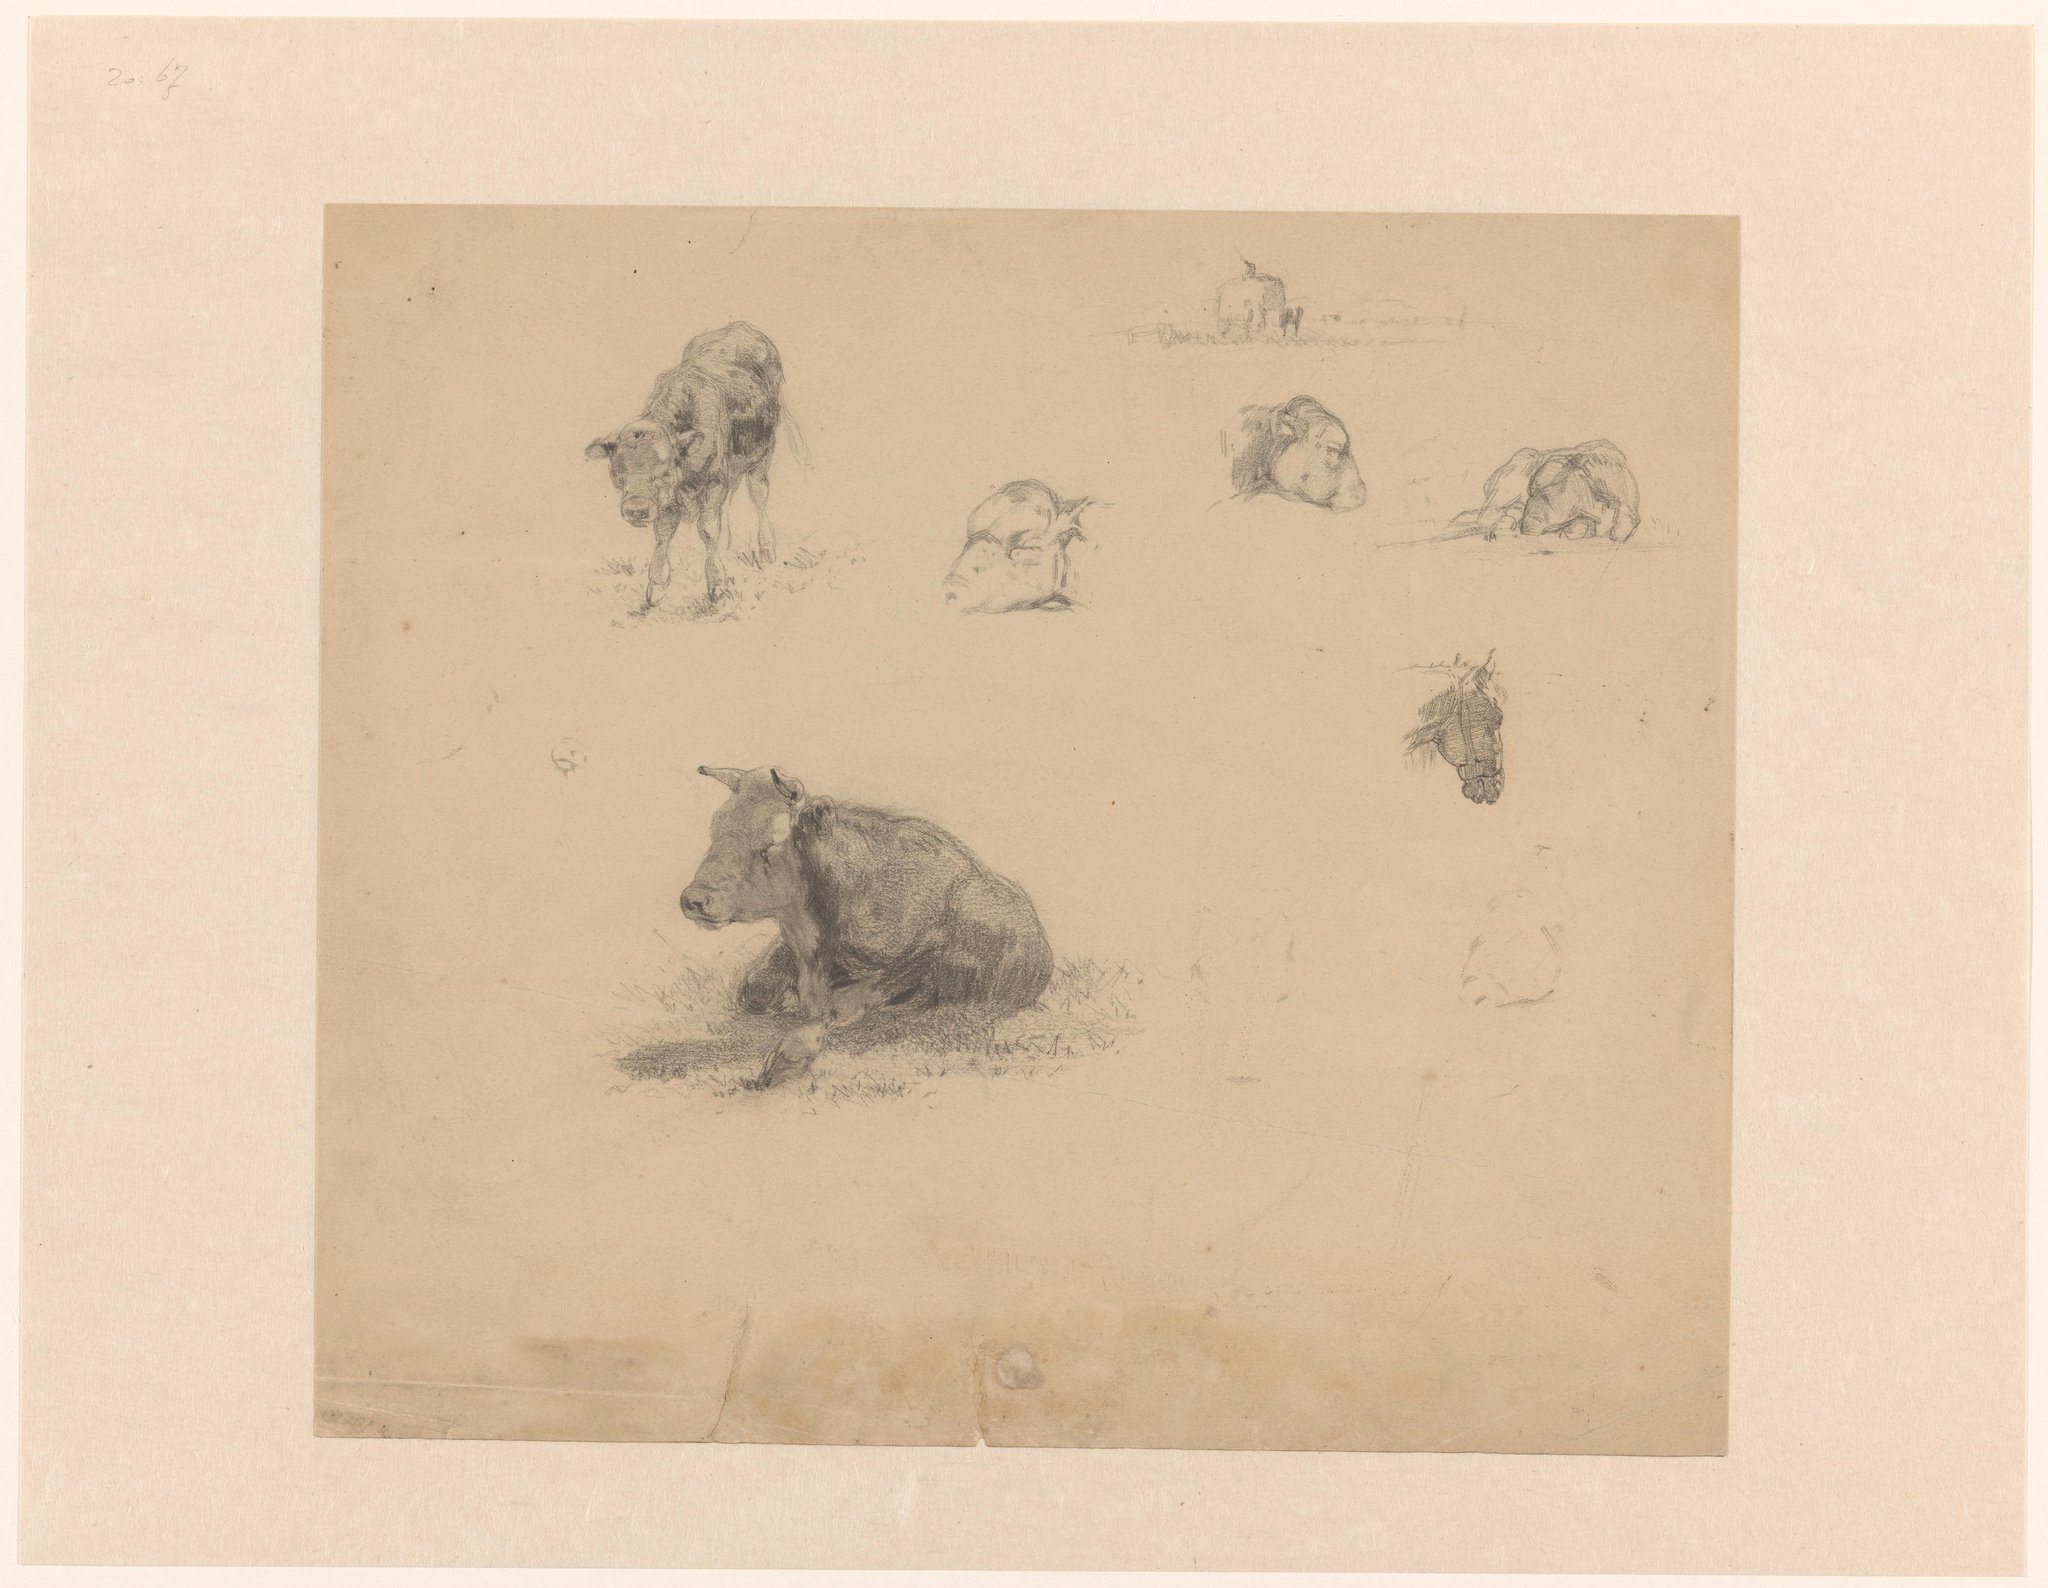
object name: drawing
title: Studies van koeien, een kalf een een paardenhoofd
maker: willem maris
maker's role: draughtsman, painter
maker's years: 1844-1910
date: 1854-1910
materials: chalk, paper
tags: cow, calf, horse